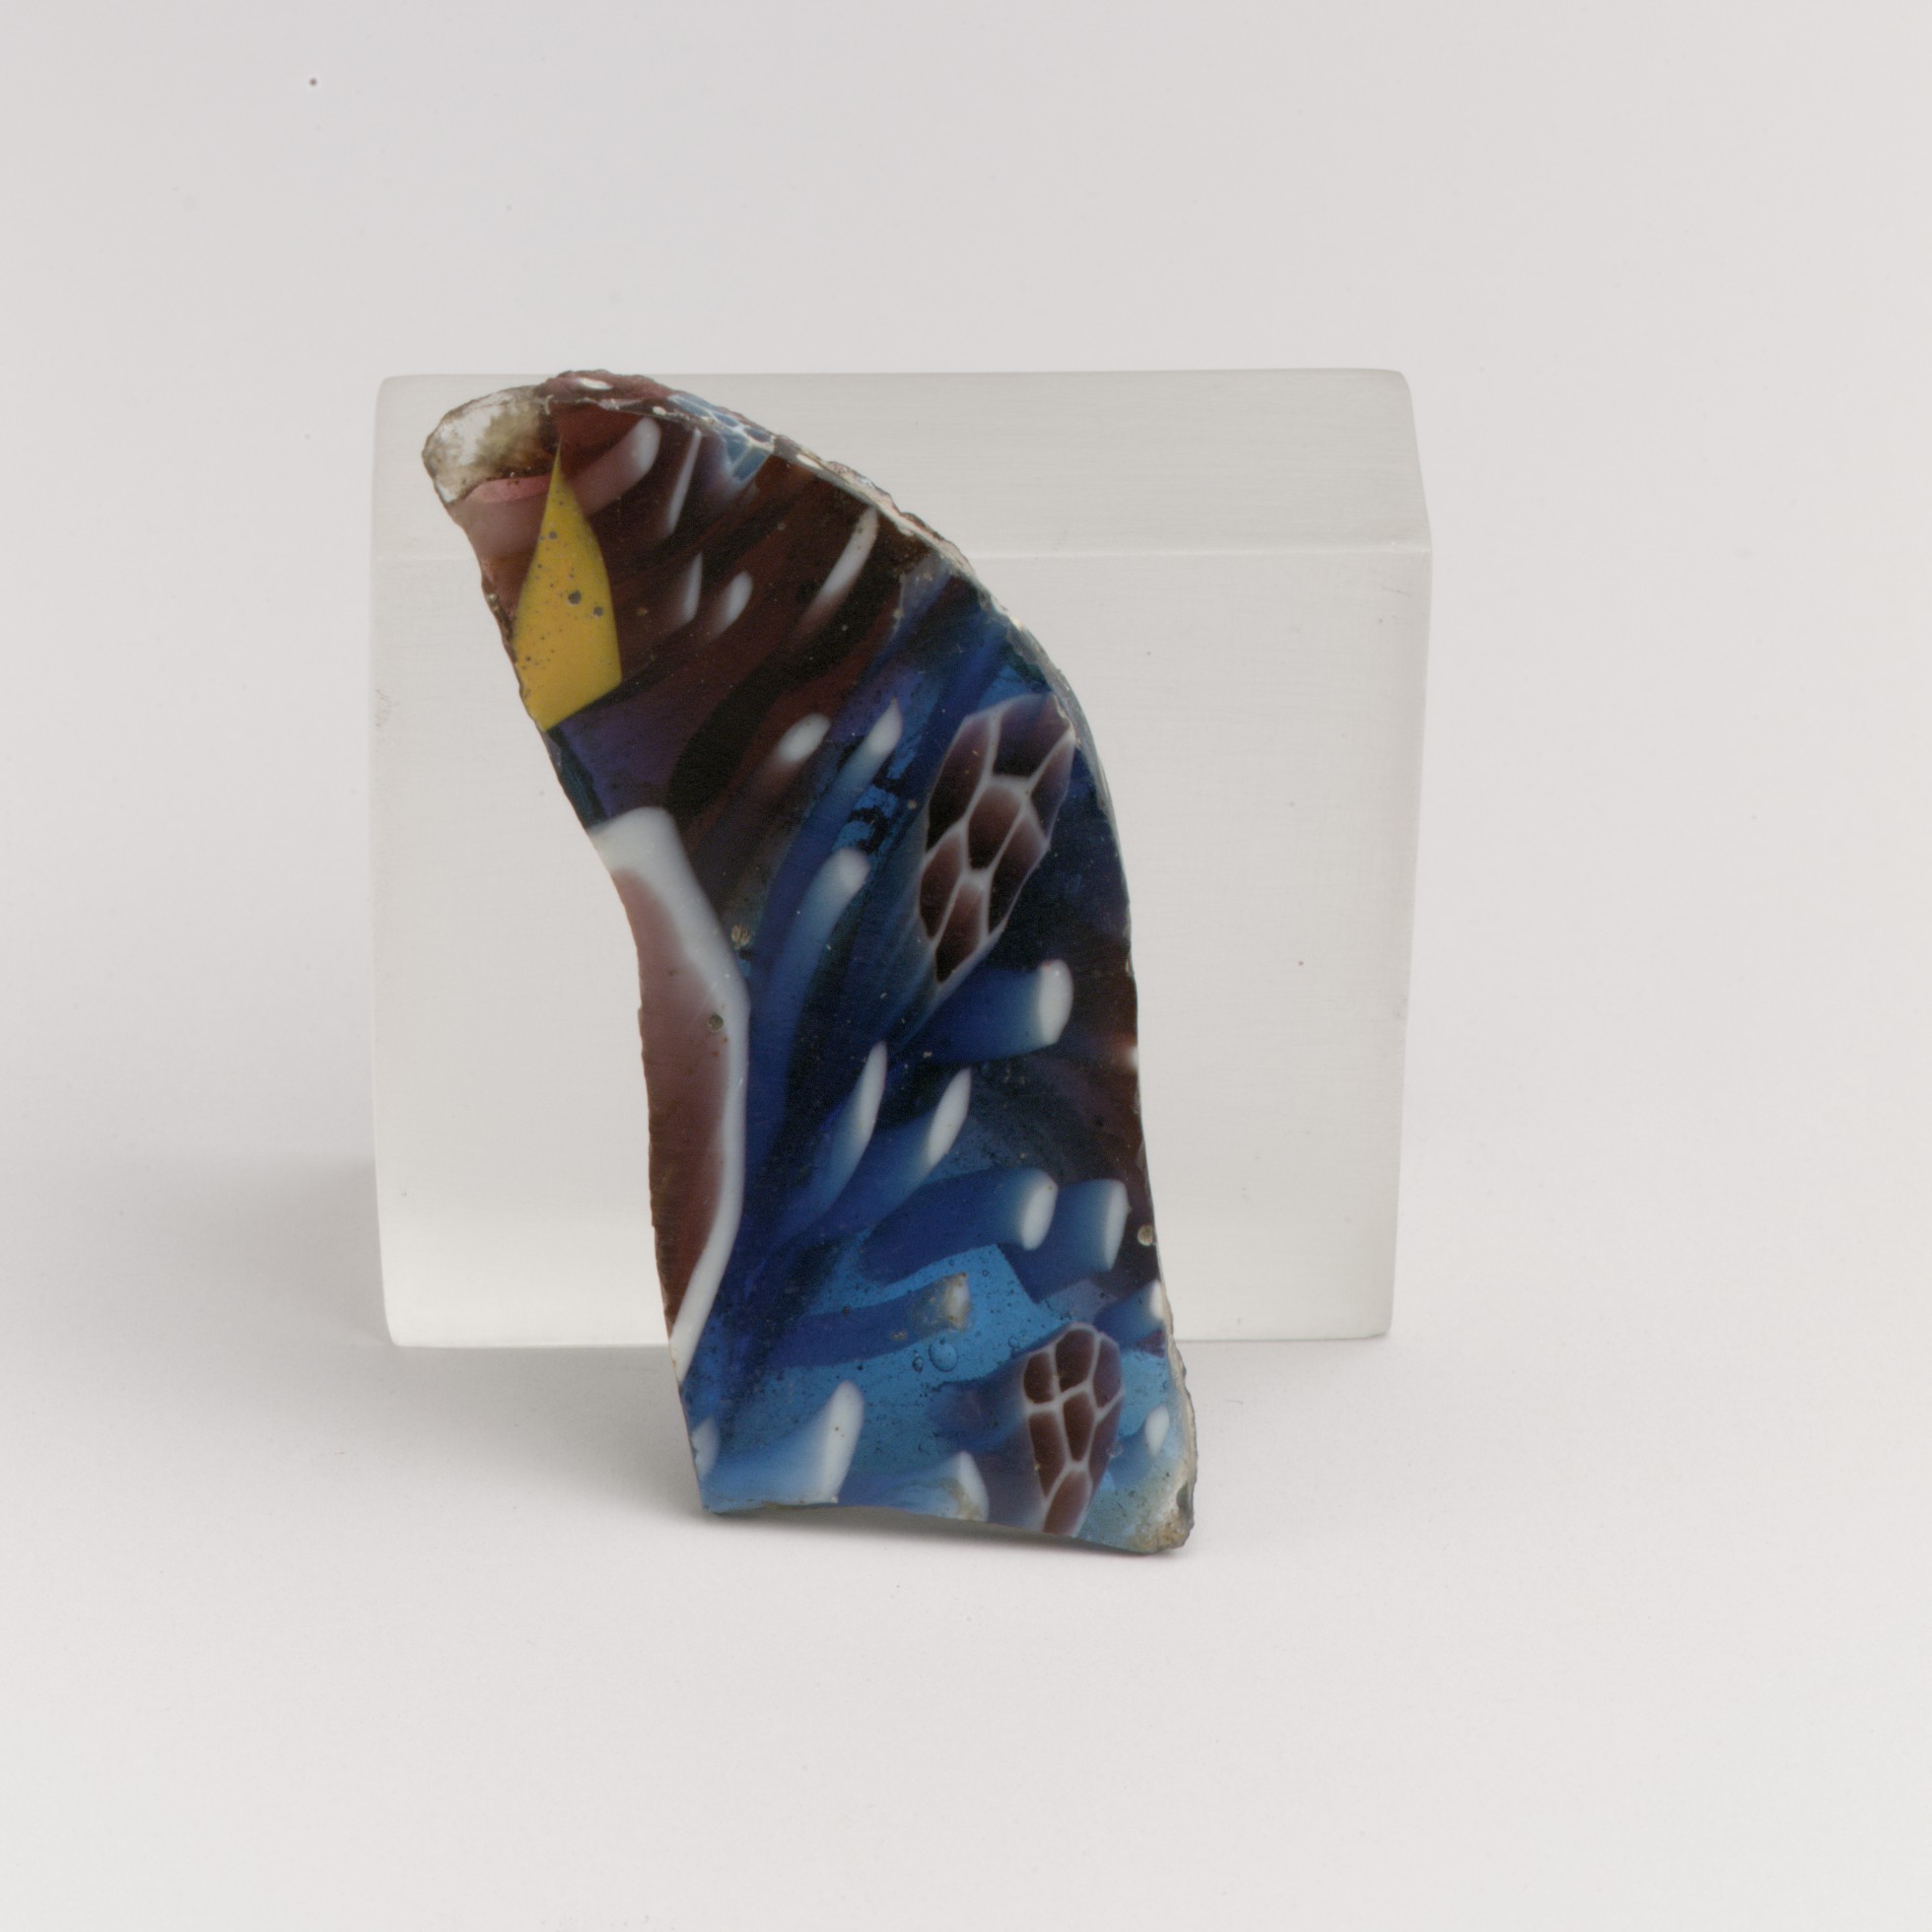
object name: fragment, mosaic bowl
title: Glass mosaic ribbed bowl fragment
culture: roman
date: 34 BCE-33 CE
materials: glass